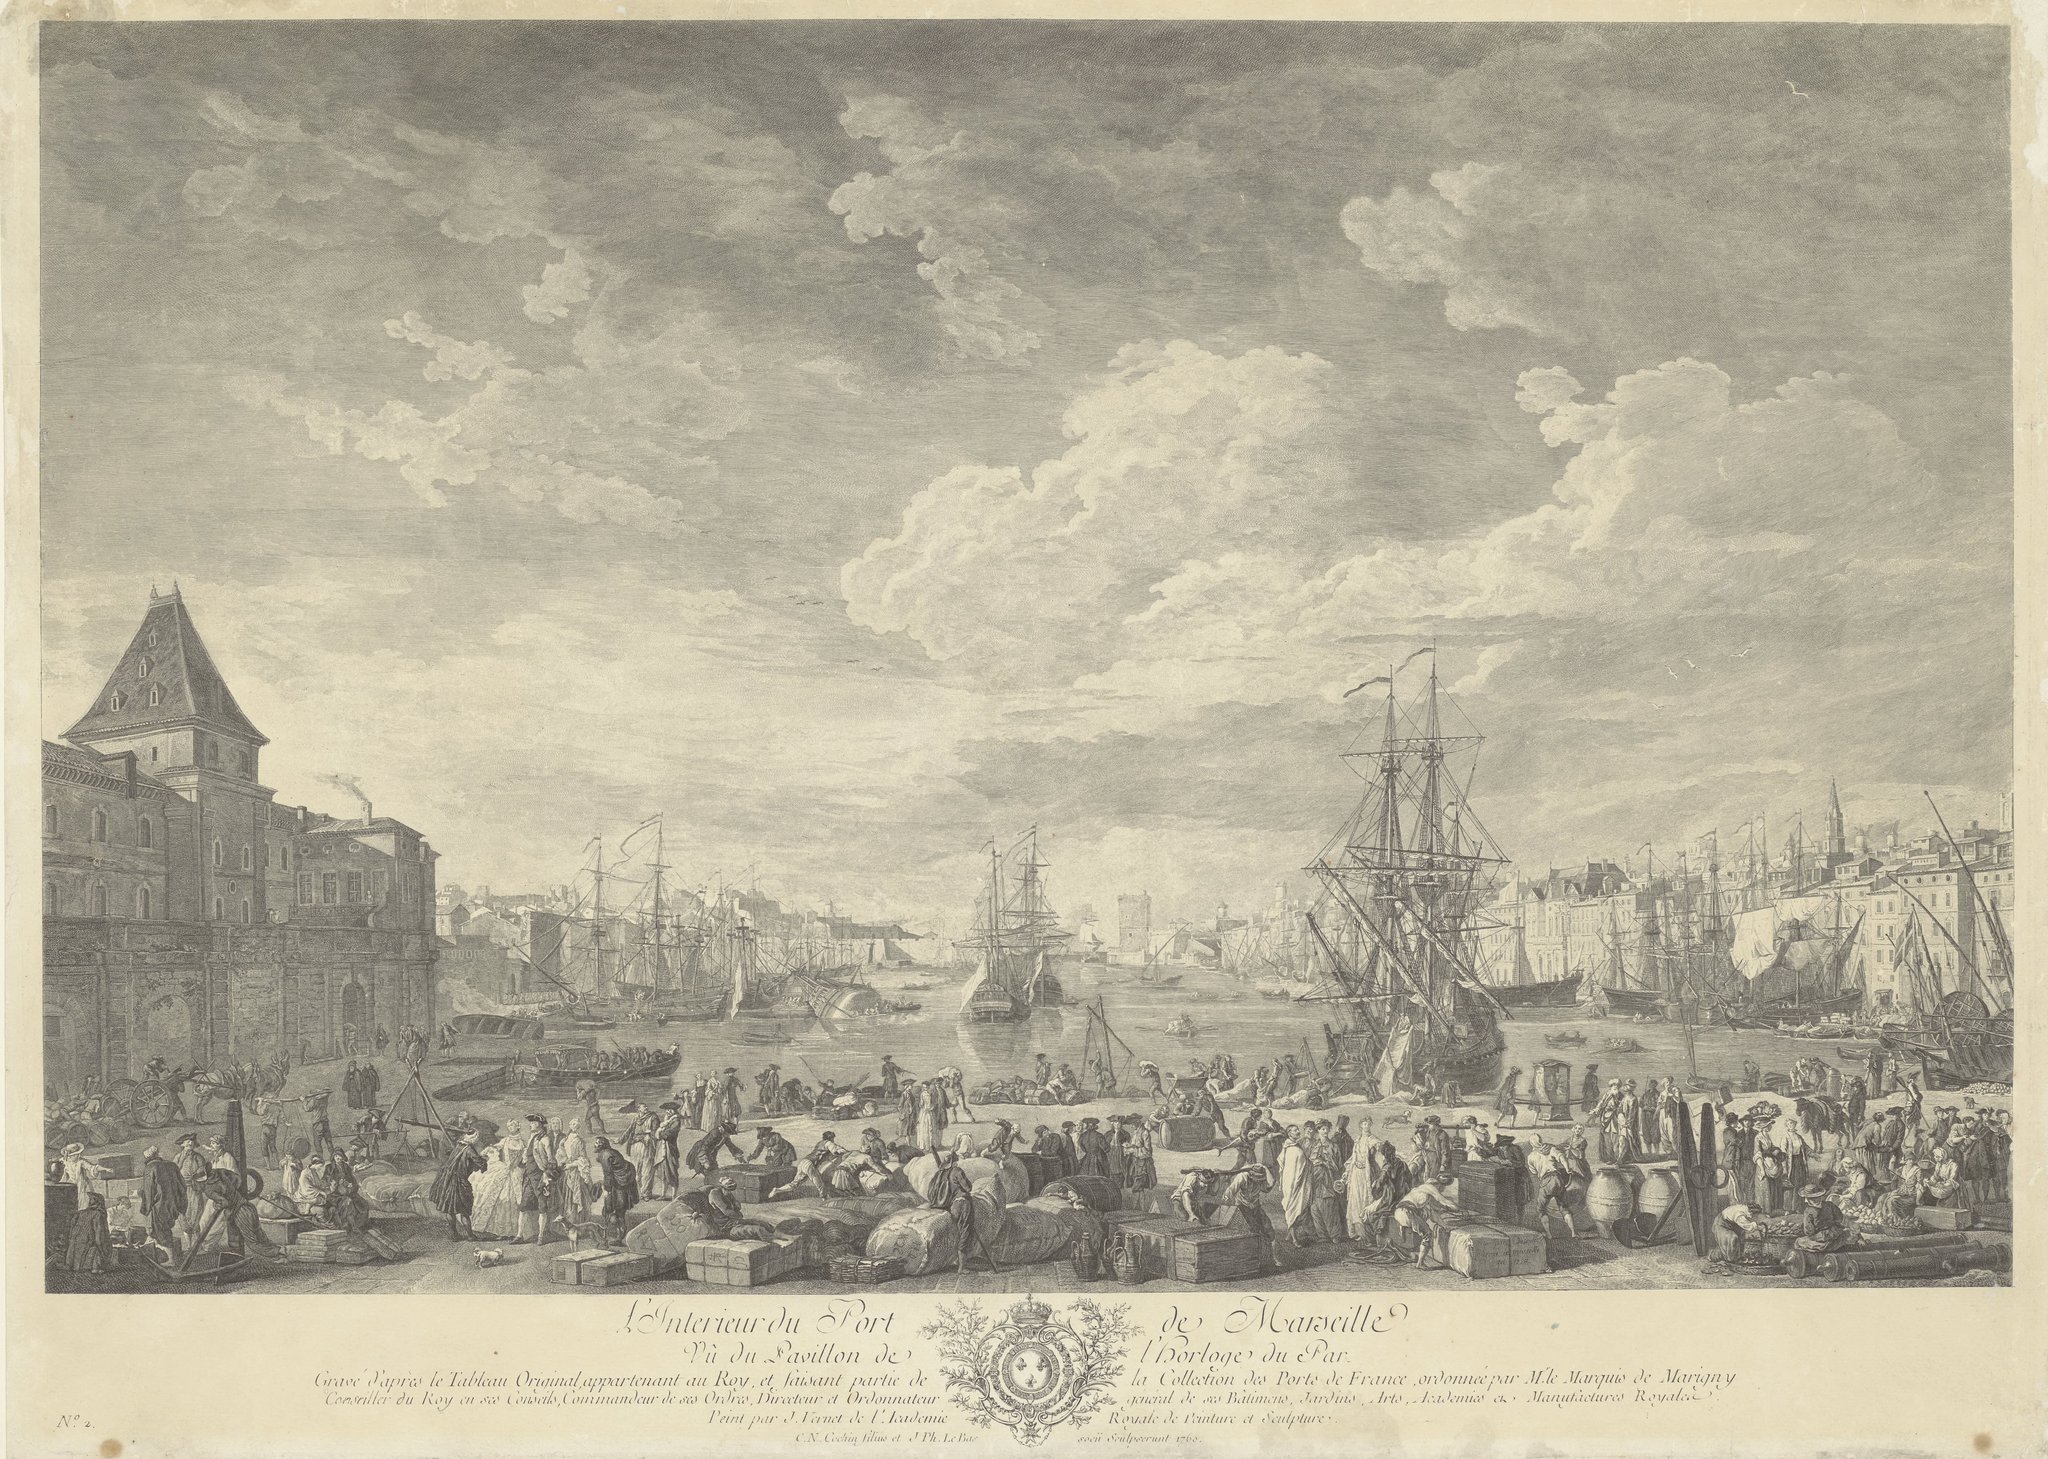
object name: print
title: Gezicht op de haven van Marseille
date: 1760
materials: paper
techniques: engraving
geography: france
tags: harbour, marseille